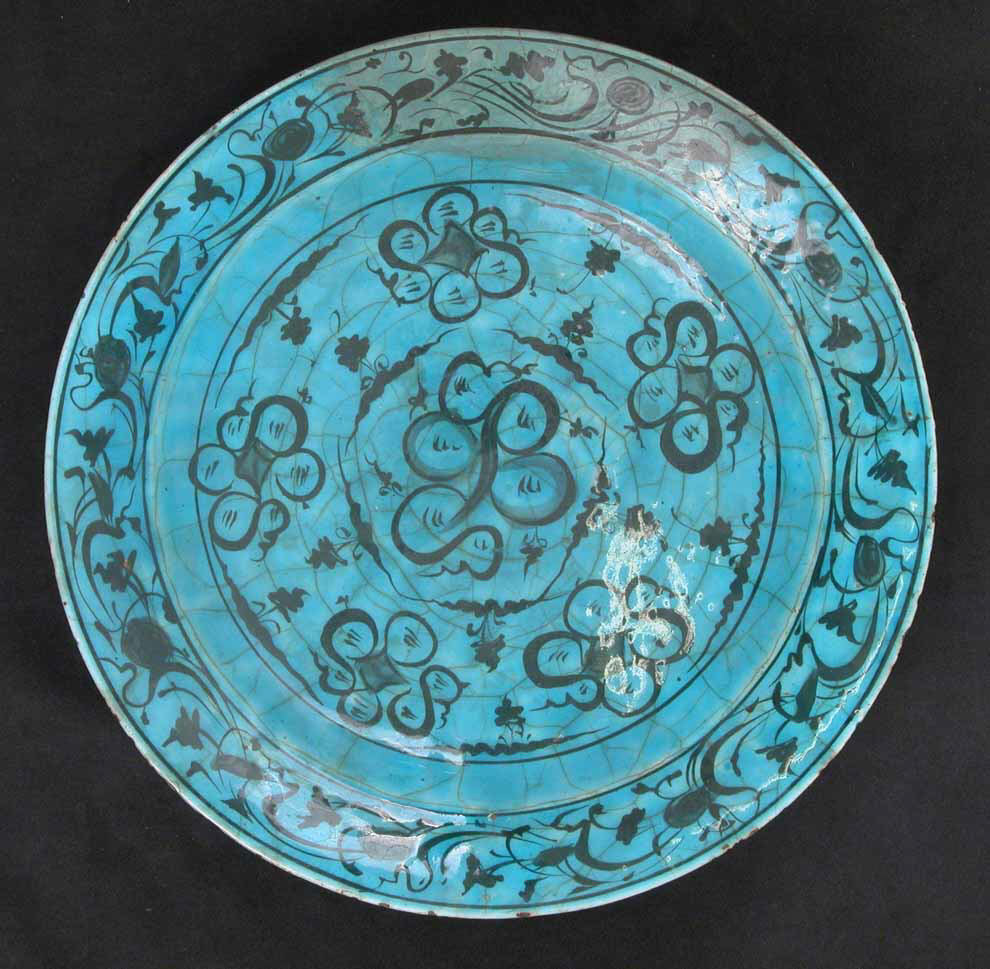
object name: dish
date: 1601-1650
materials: glaze, stonepaste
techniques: painting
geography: iran